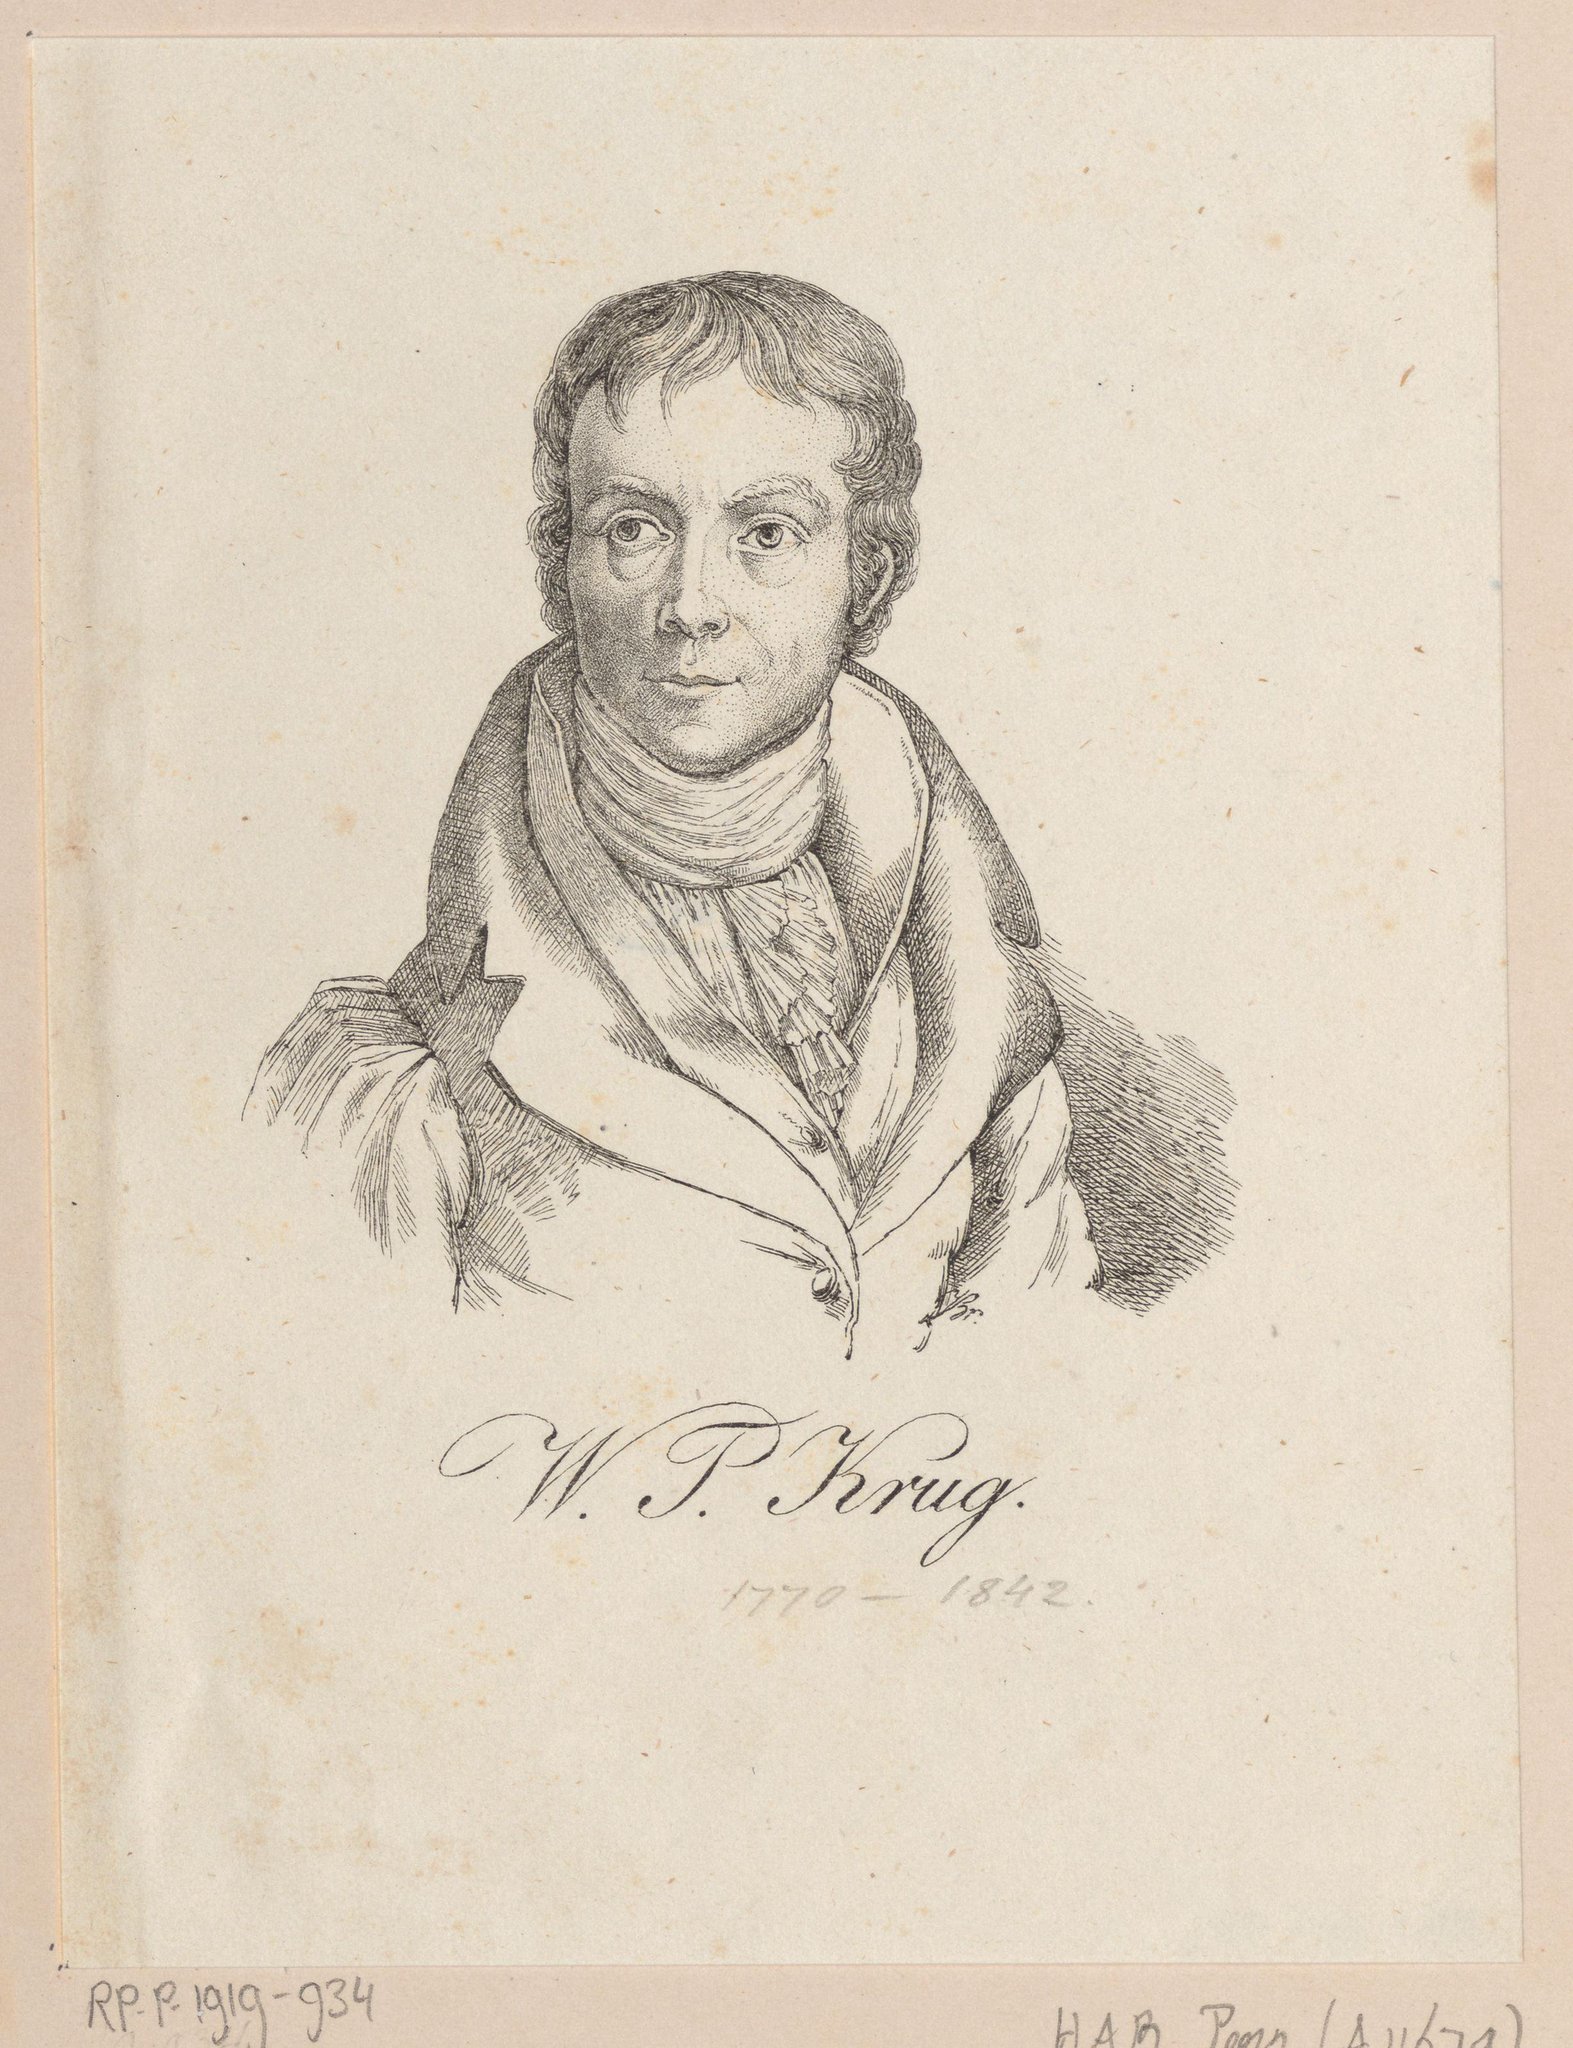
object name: print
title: Portret van Wilhelm Traugott Krug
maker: Anonymous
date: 1790-1899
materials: paper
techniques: etching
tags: historical persons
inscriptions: collector's mark: Lugt 2228, signature: ‘Vjr of Hjr’